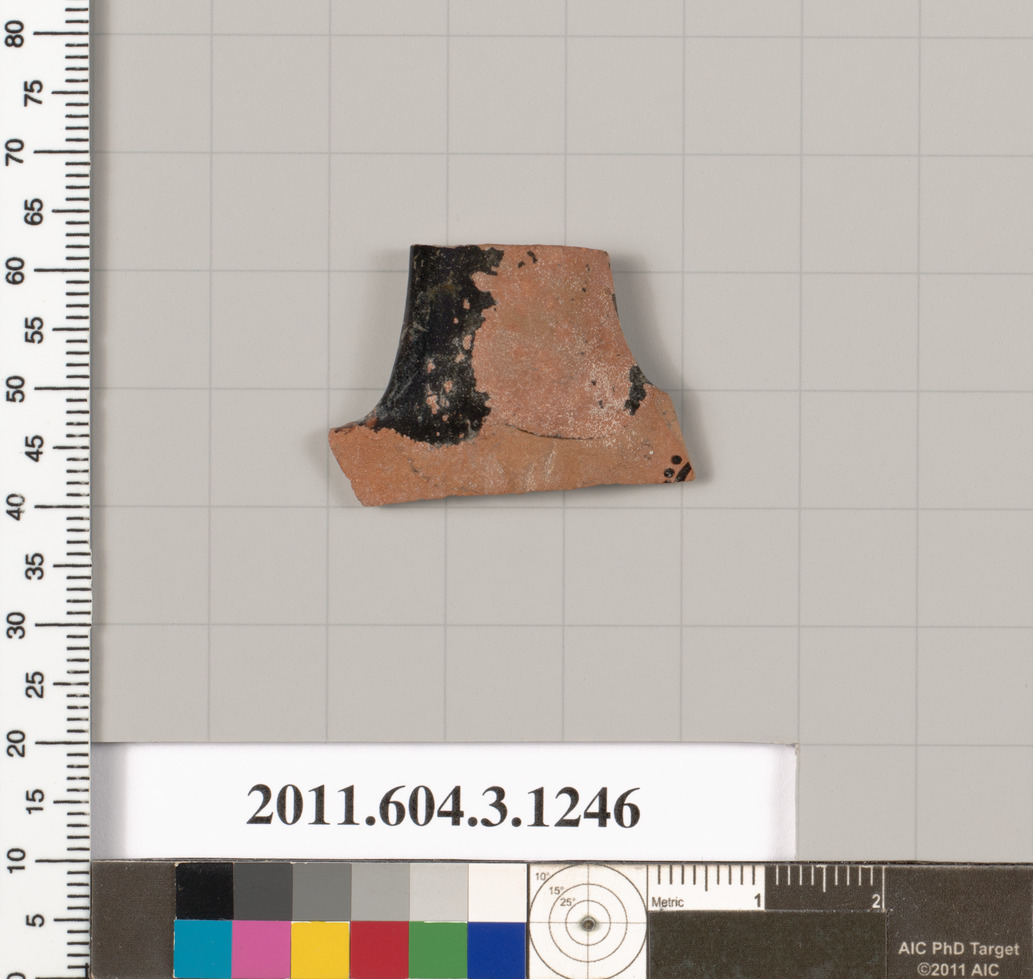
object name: kyathos fragment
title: Terracotta fragment of a kyathos (cup-shaped ladle)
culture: greek, attic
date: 534-468 BCE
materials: terracotta